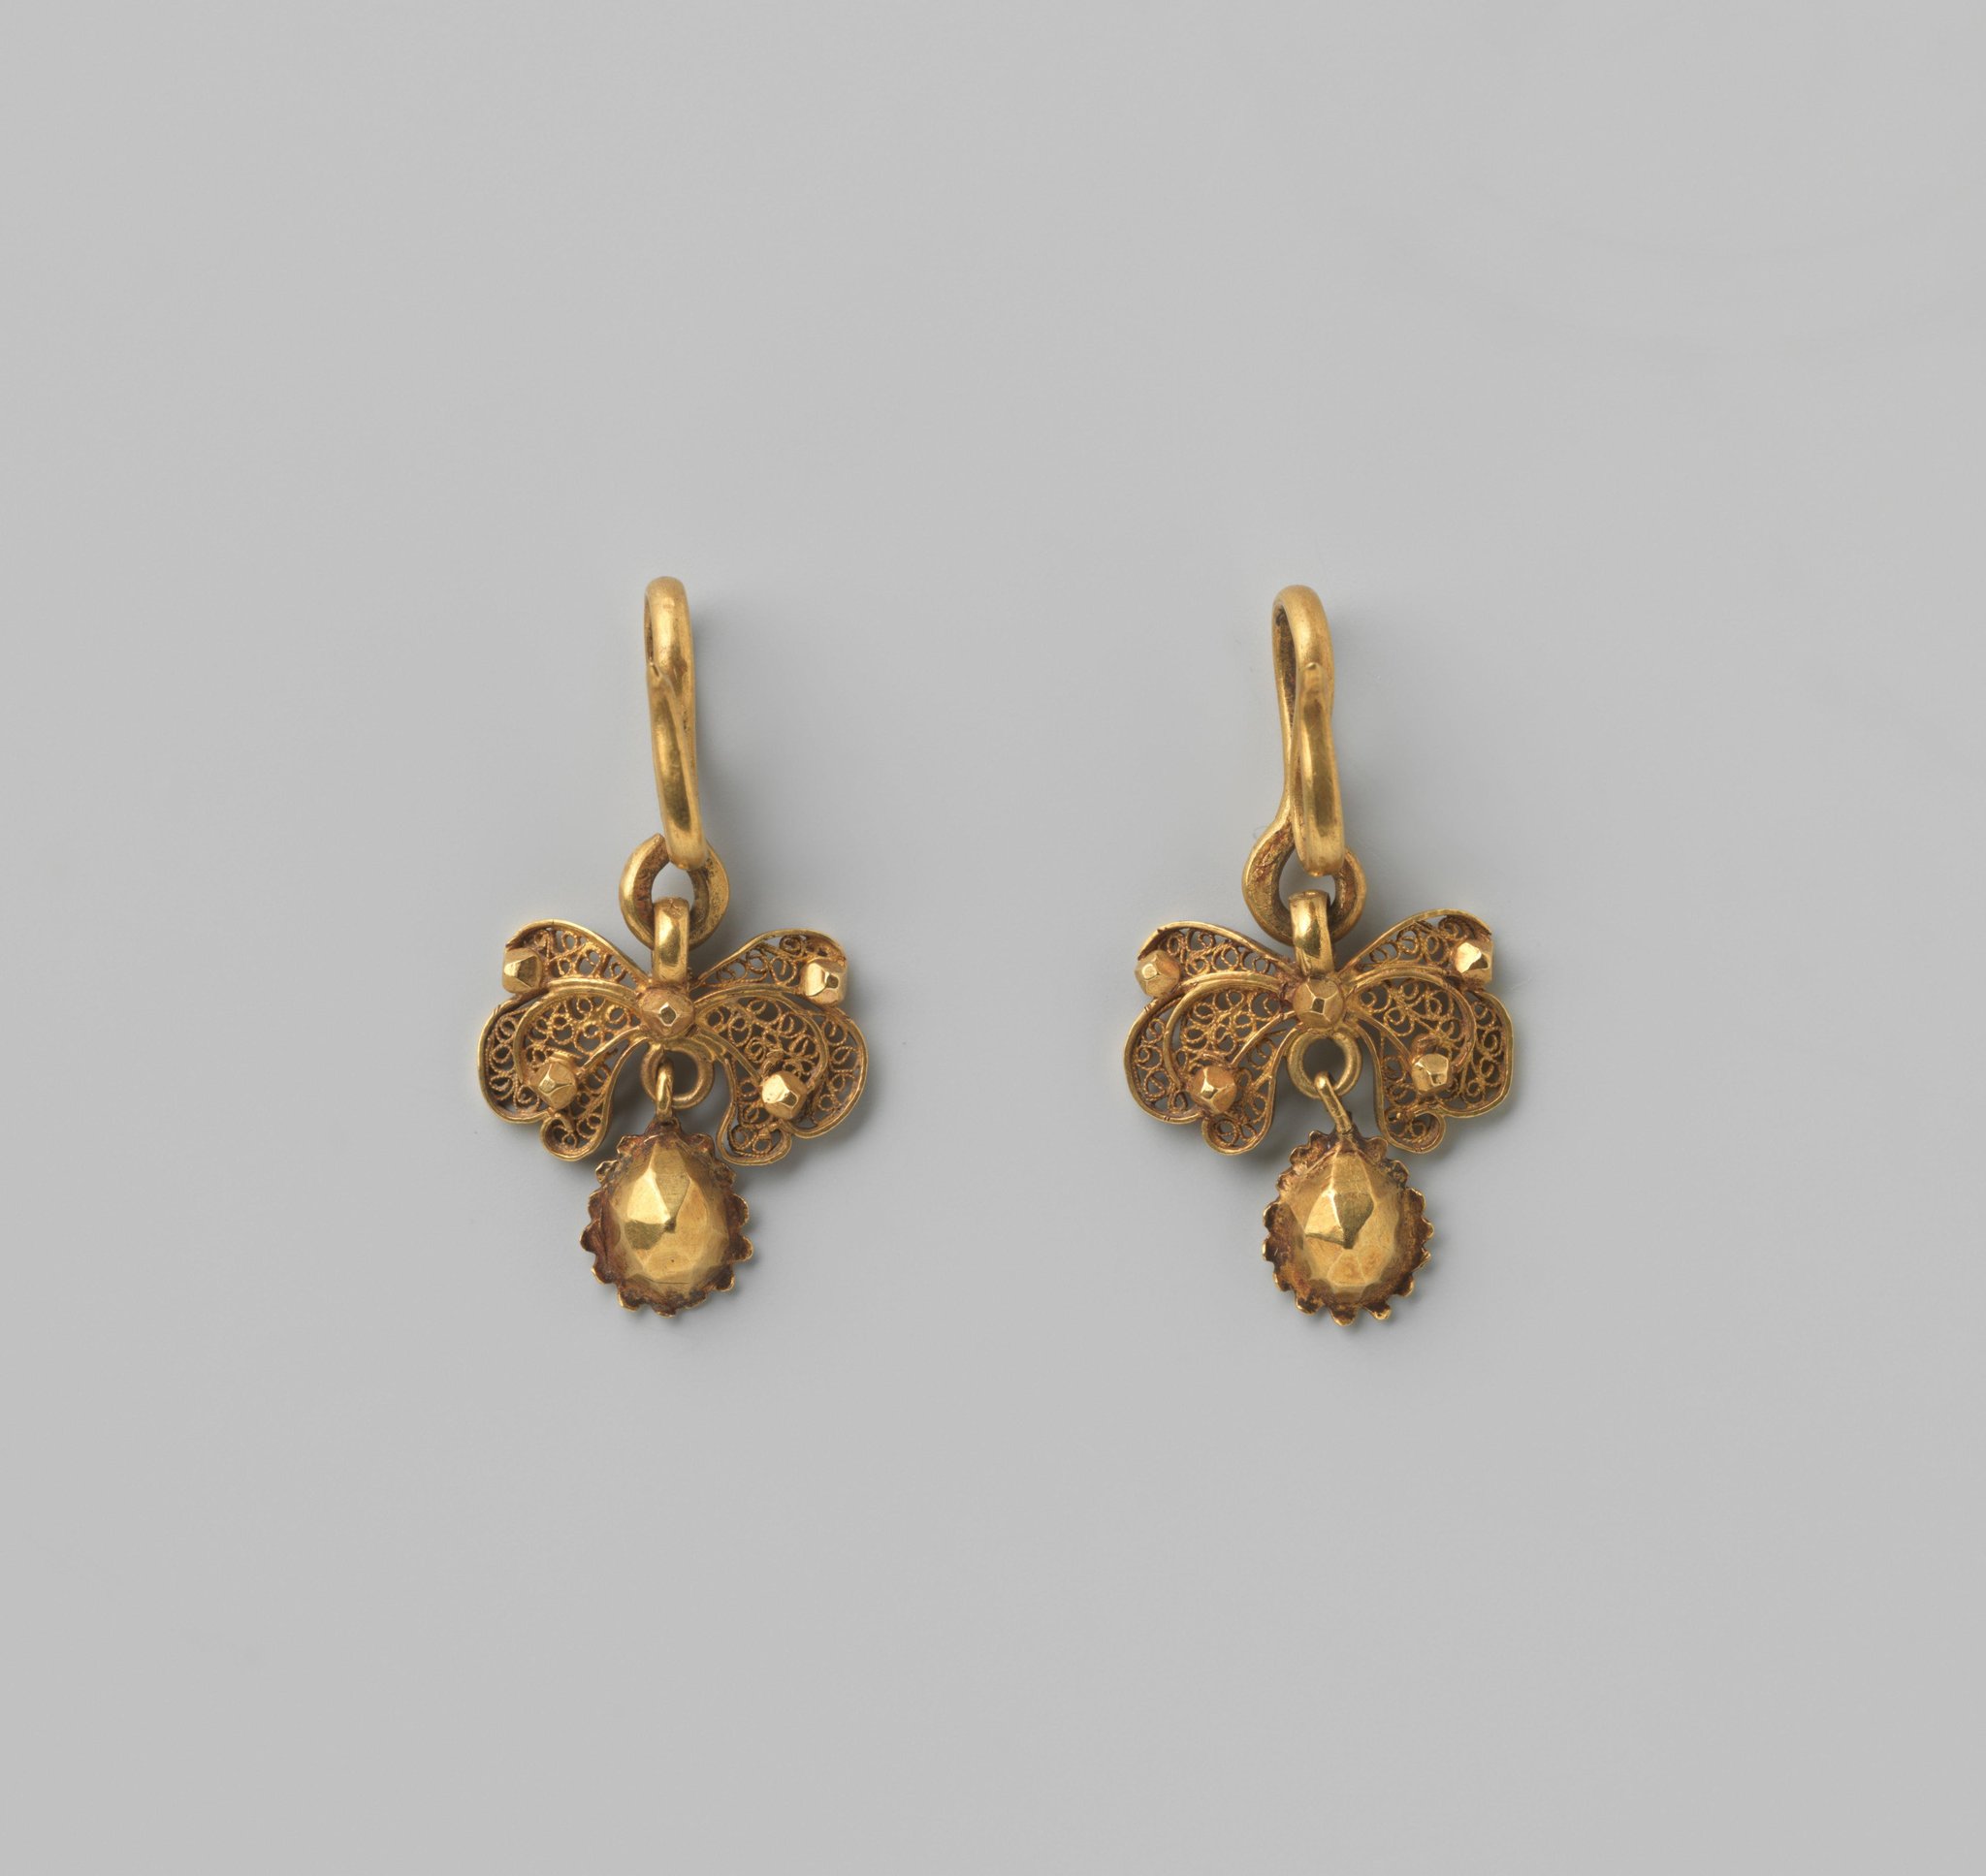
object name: jewellery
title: Paar oorhangers van goud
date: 1700-1850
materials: gold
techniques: filigree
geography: amsterdam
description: Een paar gouden oorhangers. Vlindervormig met een aanhangend knopje. Het is gedeeltelijk van filigrein.